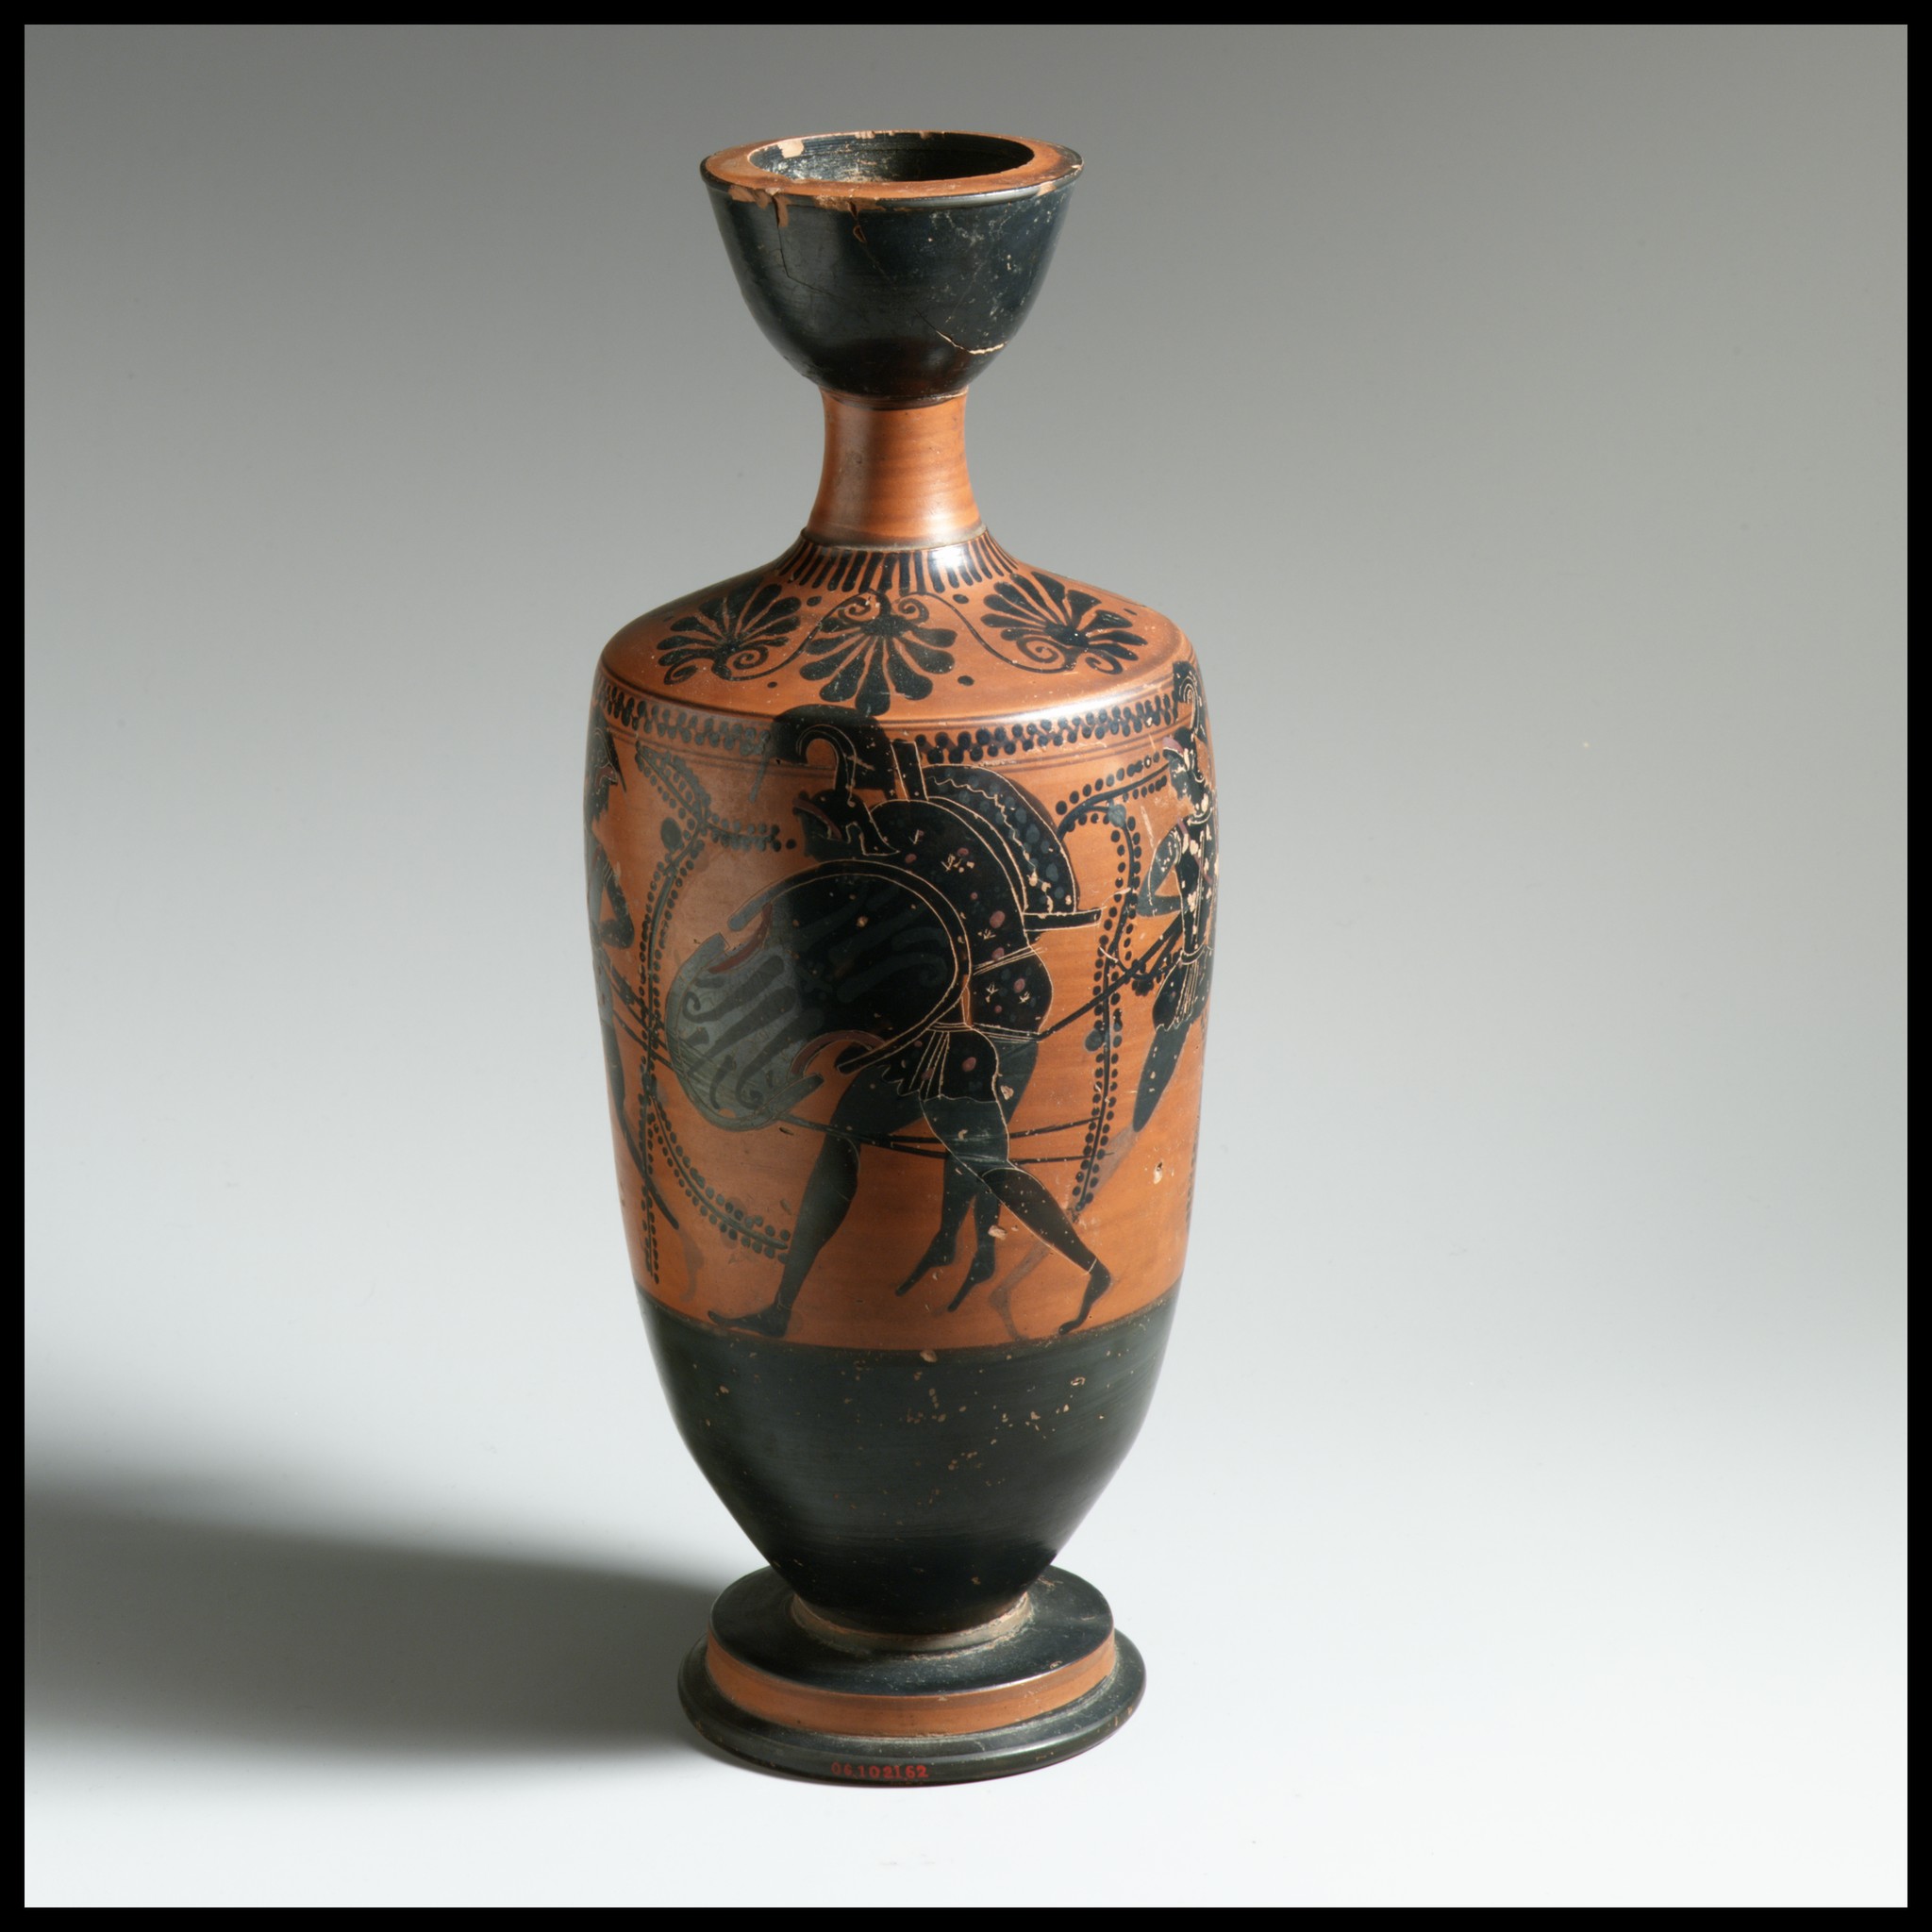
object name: lekythos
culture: greek, attic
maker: capodimonte group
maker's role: artist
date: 534-501 BCE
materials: terracotta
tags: shields,amazons